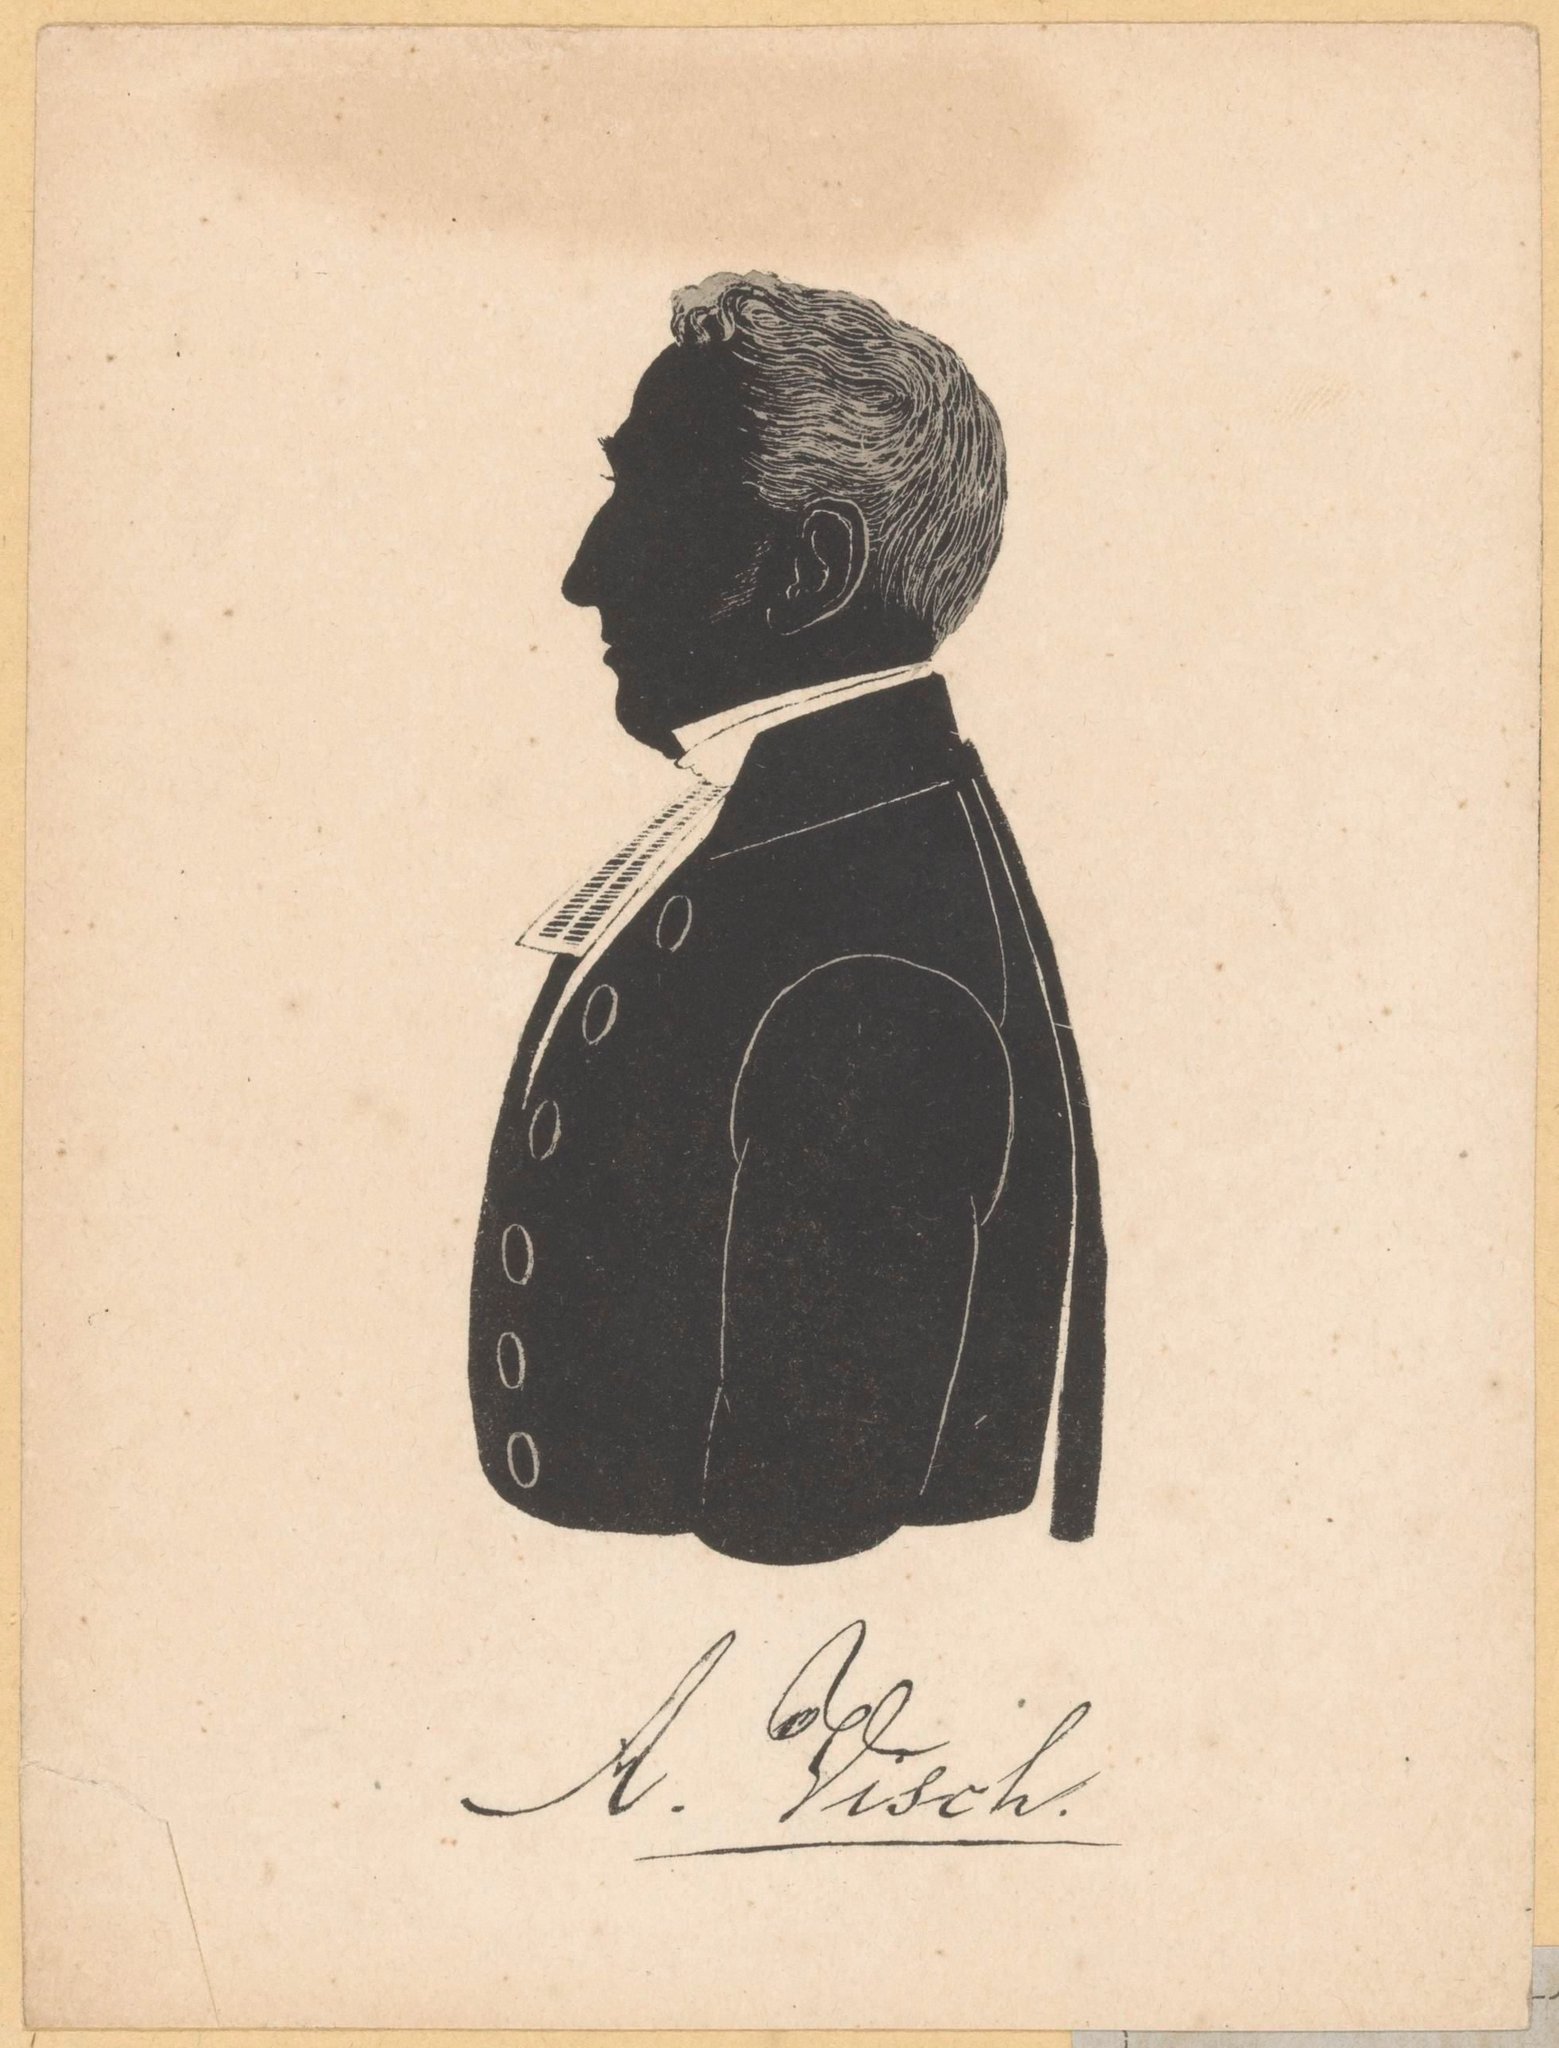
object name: print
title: Silhouetportret van Adam Visch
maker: pieter barbiers (iv)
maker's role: painter, print maker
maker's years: 1798-1848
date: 1809-1848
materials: paper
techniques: hand coloring, lithograph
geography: netherlands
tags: historical persons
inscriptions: collector's mark: Lugt 2228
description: Onder het portret de signatuur van de geportretteerde.